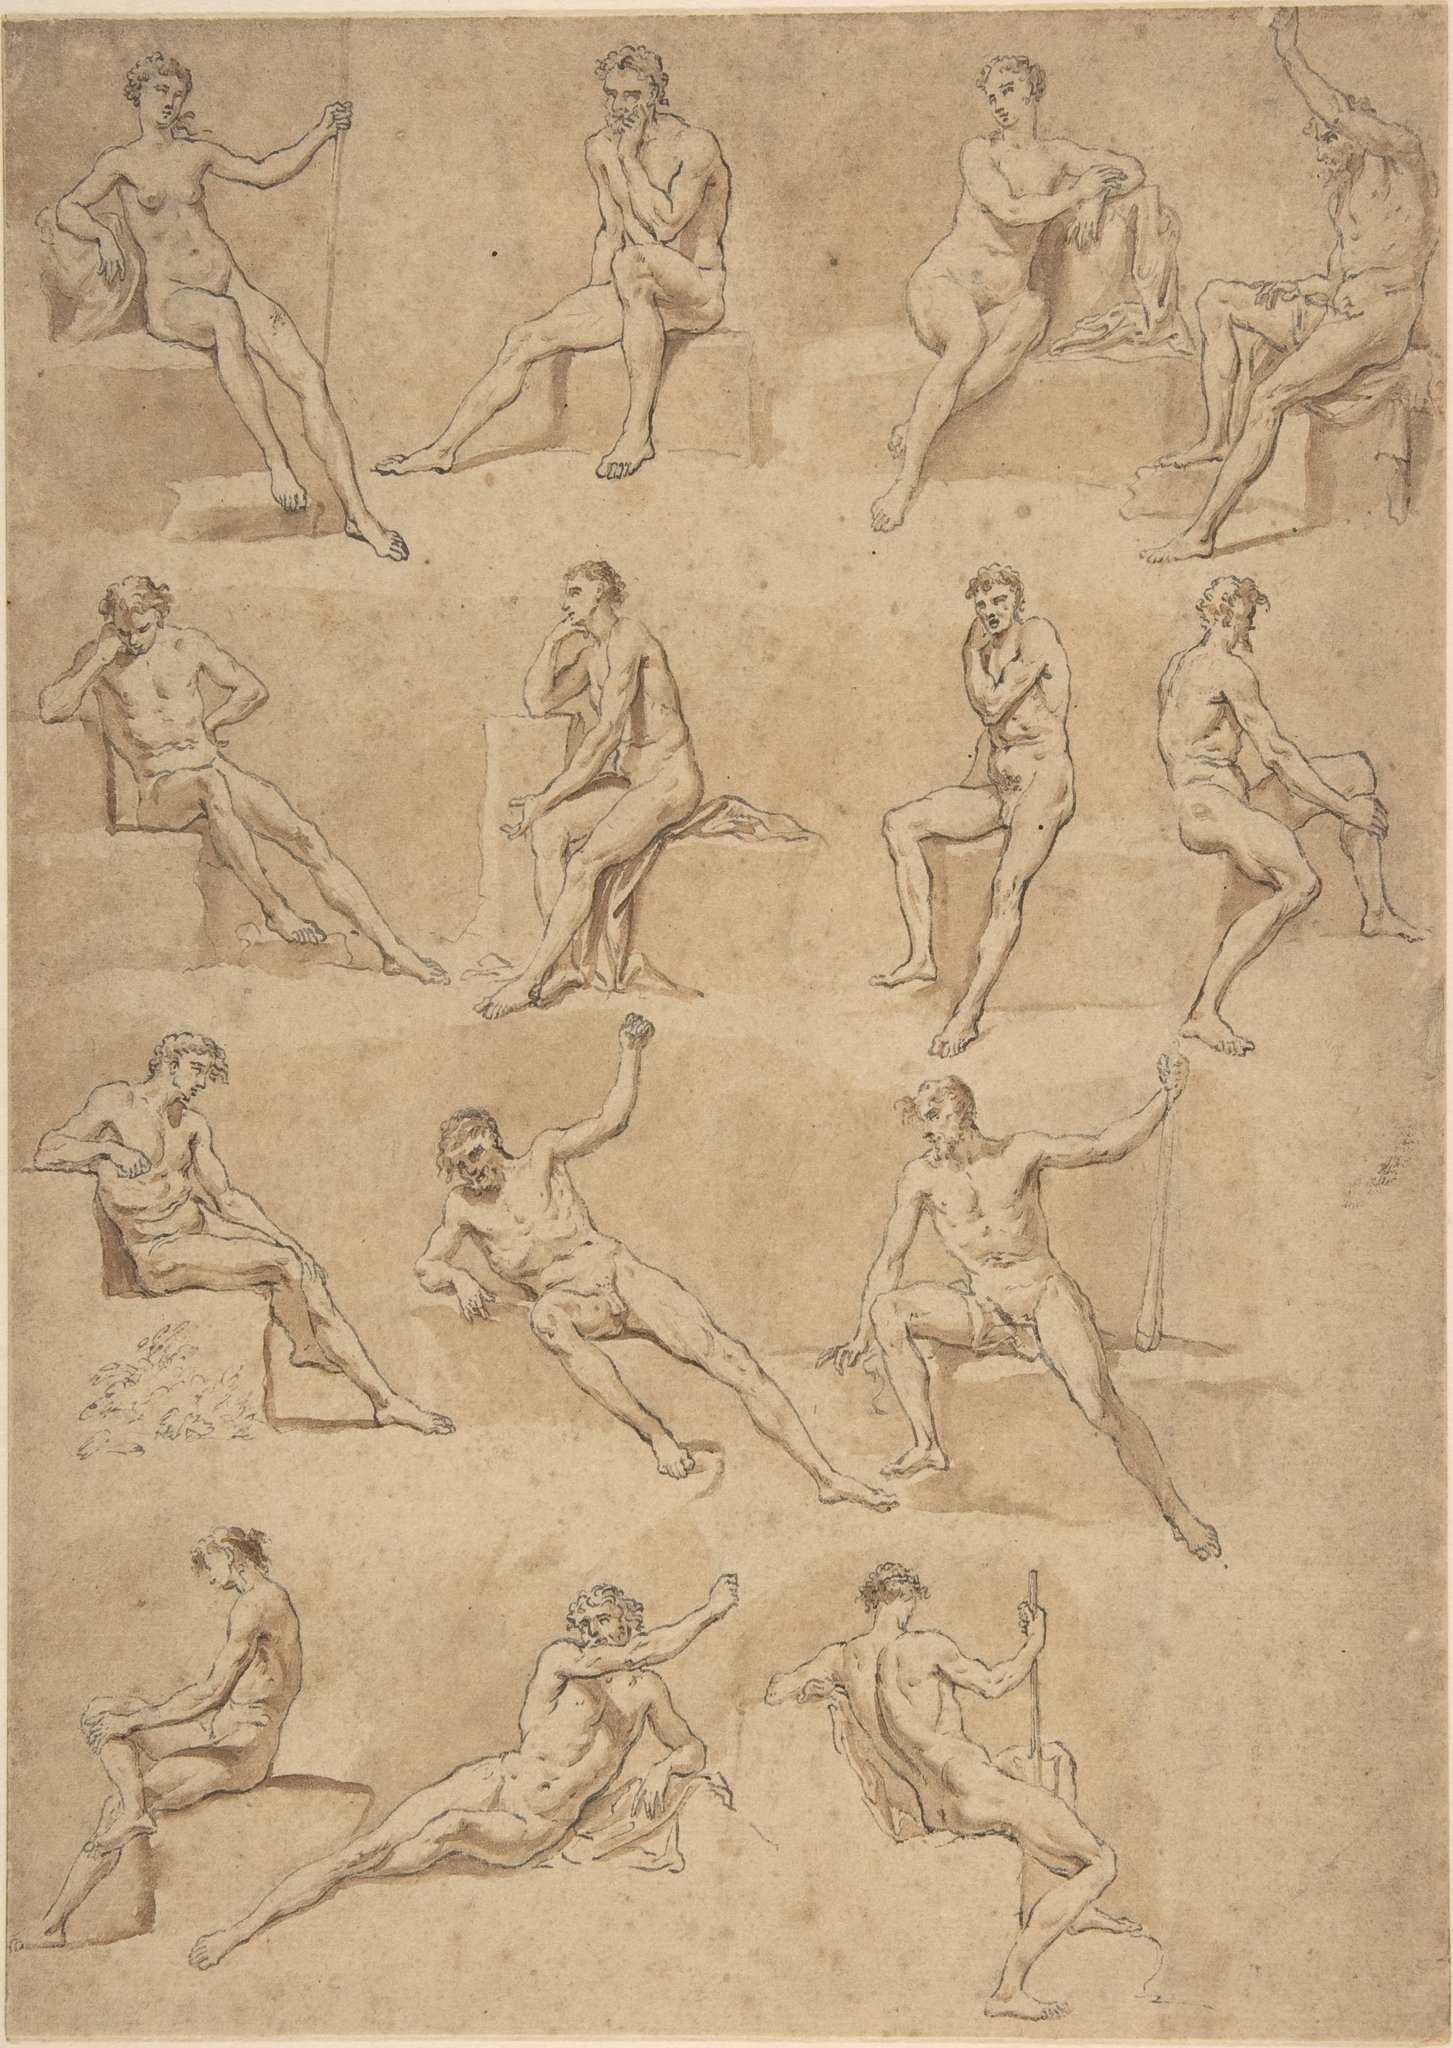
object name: drawing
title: Figure Studies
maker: hubert françois gravelot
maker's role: artist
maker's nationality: french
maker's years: 1699-1773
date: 1701-1800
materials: ink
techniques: brush, pen, wash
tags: male nudes,female nudes